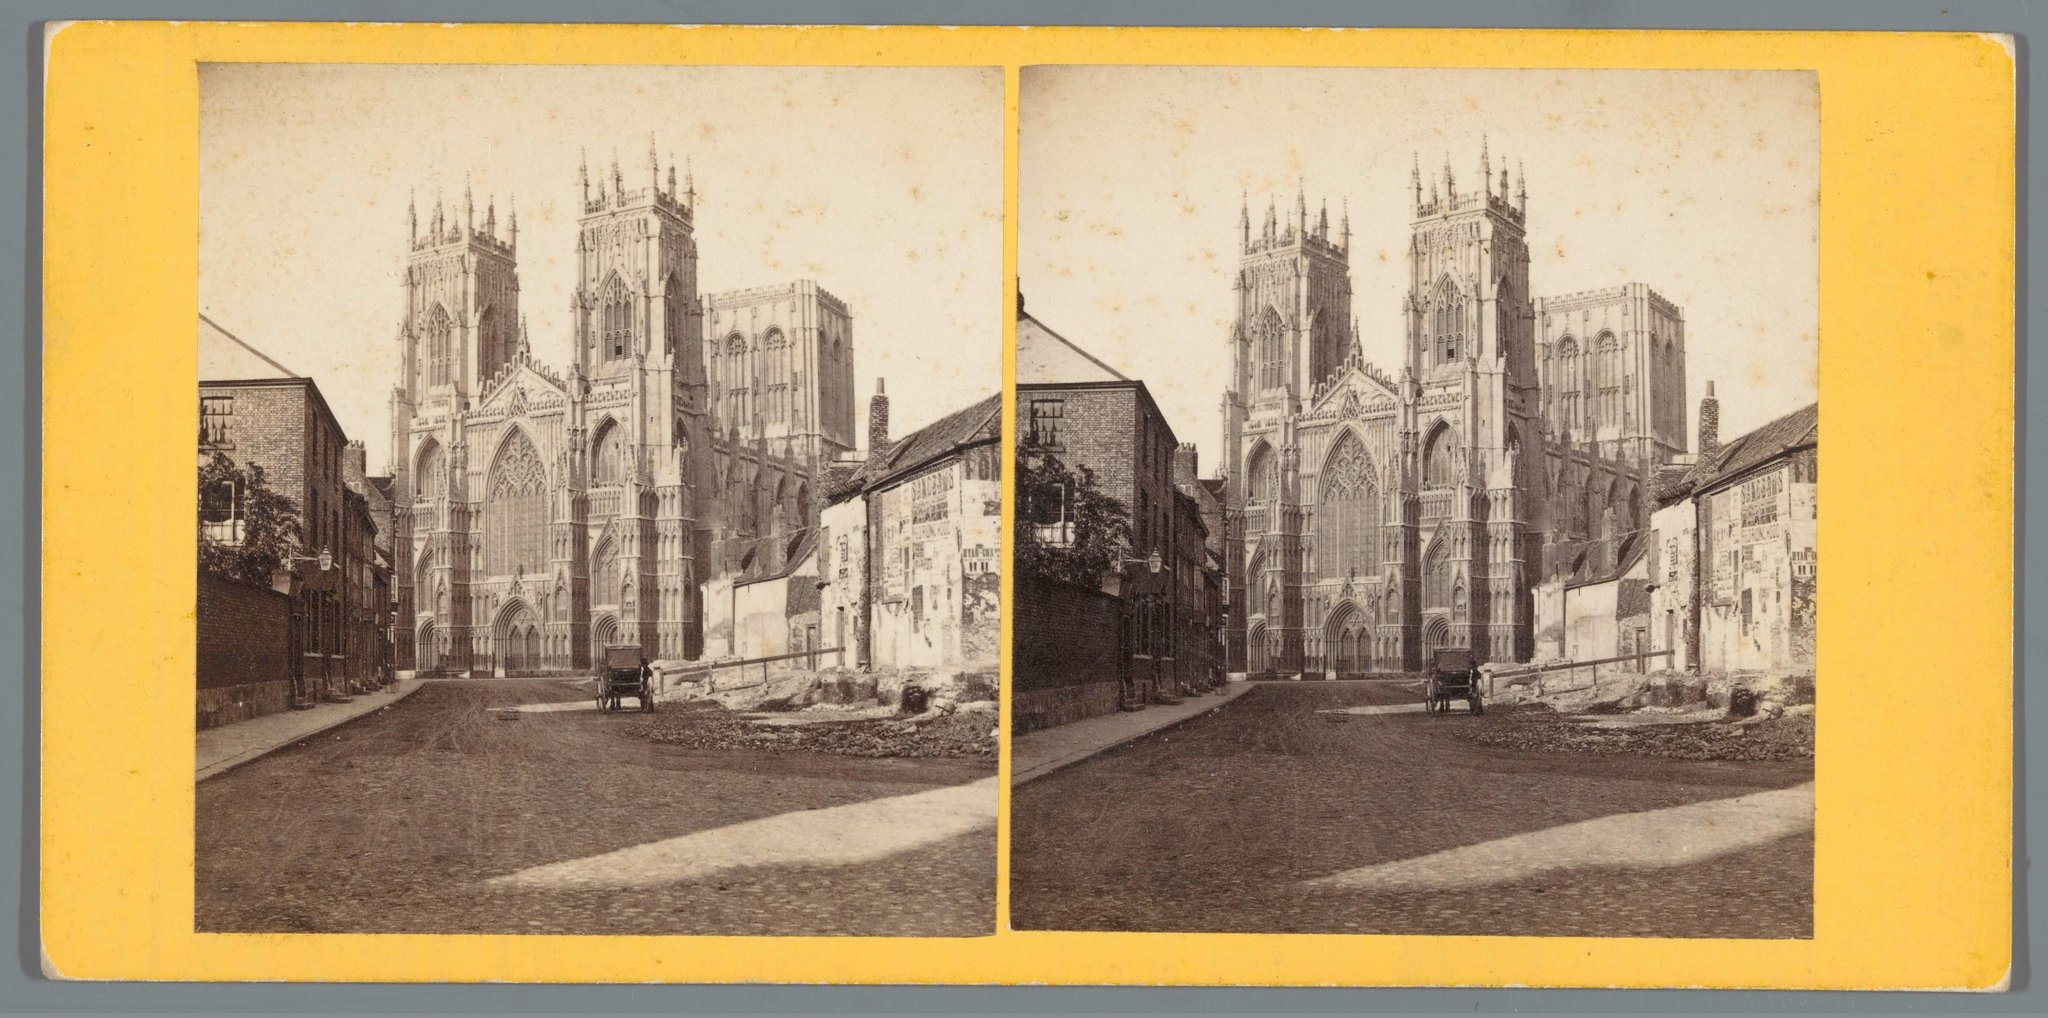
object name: stereograph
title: York Minster – West Front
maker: george washington wilson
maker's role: publisher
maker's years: 1823-1893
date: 1860-1865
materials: cardboard, photographic support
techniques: albumen print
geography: aberdeen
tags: schotland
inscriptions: label: ‘G.W. Wilson & Co, Aberdeen No. 366 York Minster – West Front’